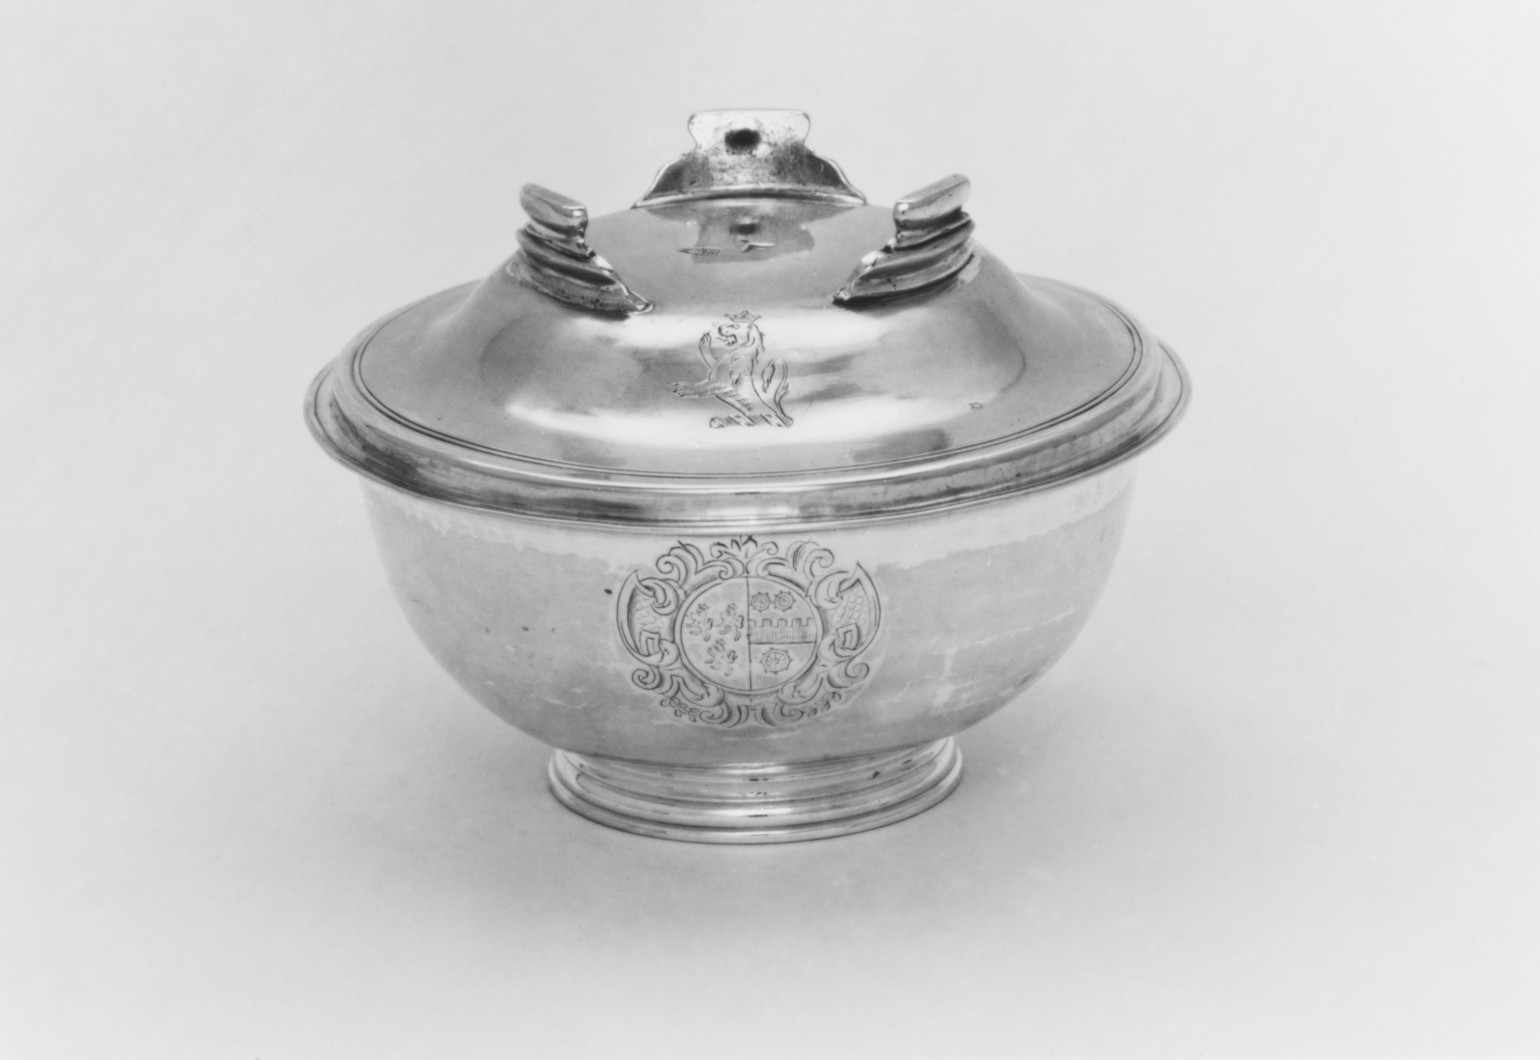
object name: sugar bowl with cover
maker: william bellassyse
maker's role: maker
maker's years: 1716-1723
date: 1720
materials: silver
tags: coat of arms